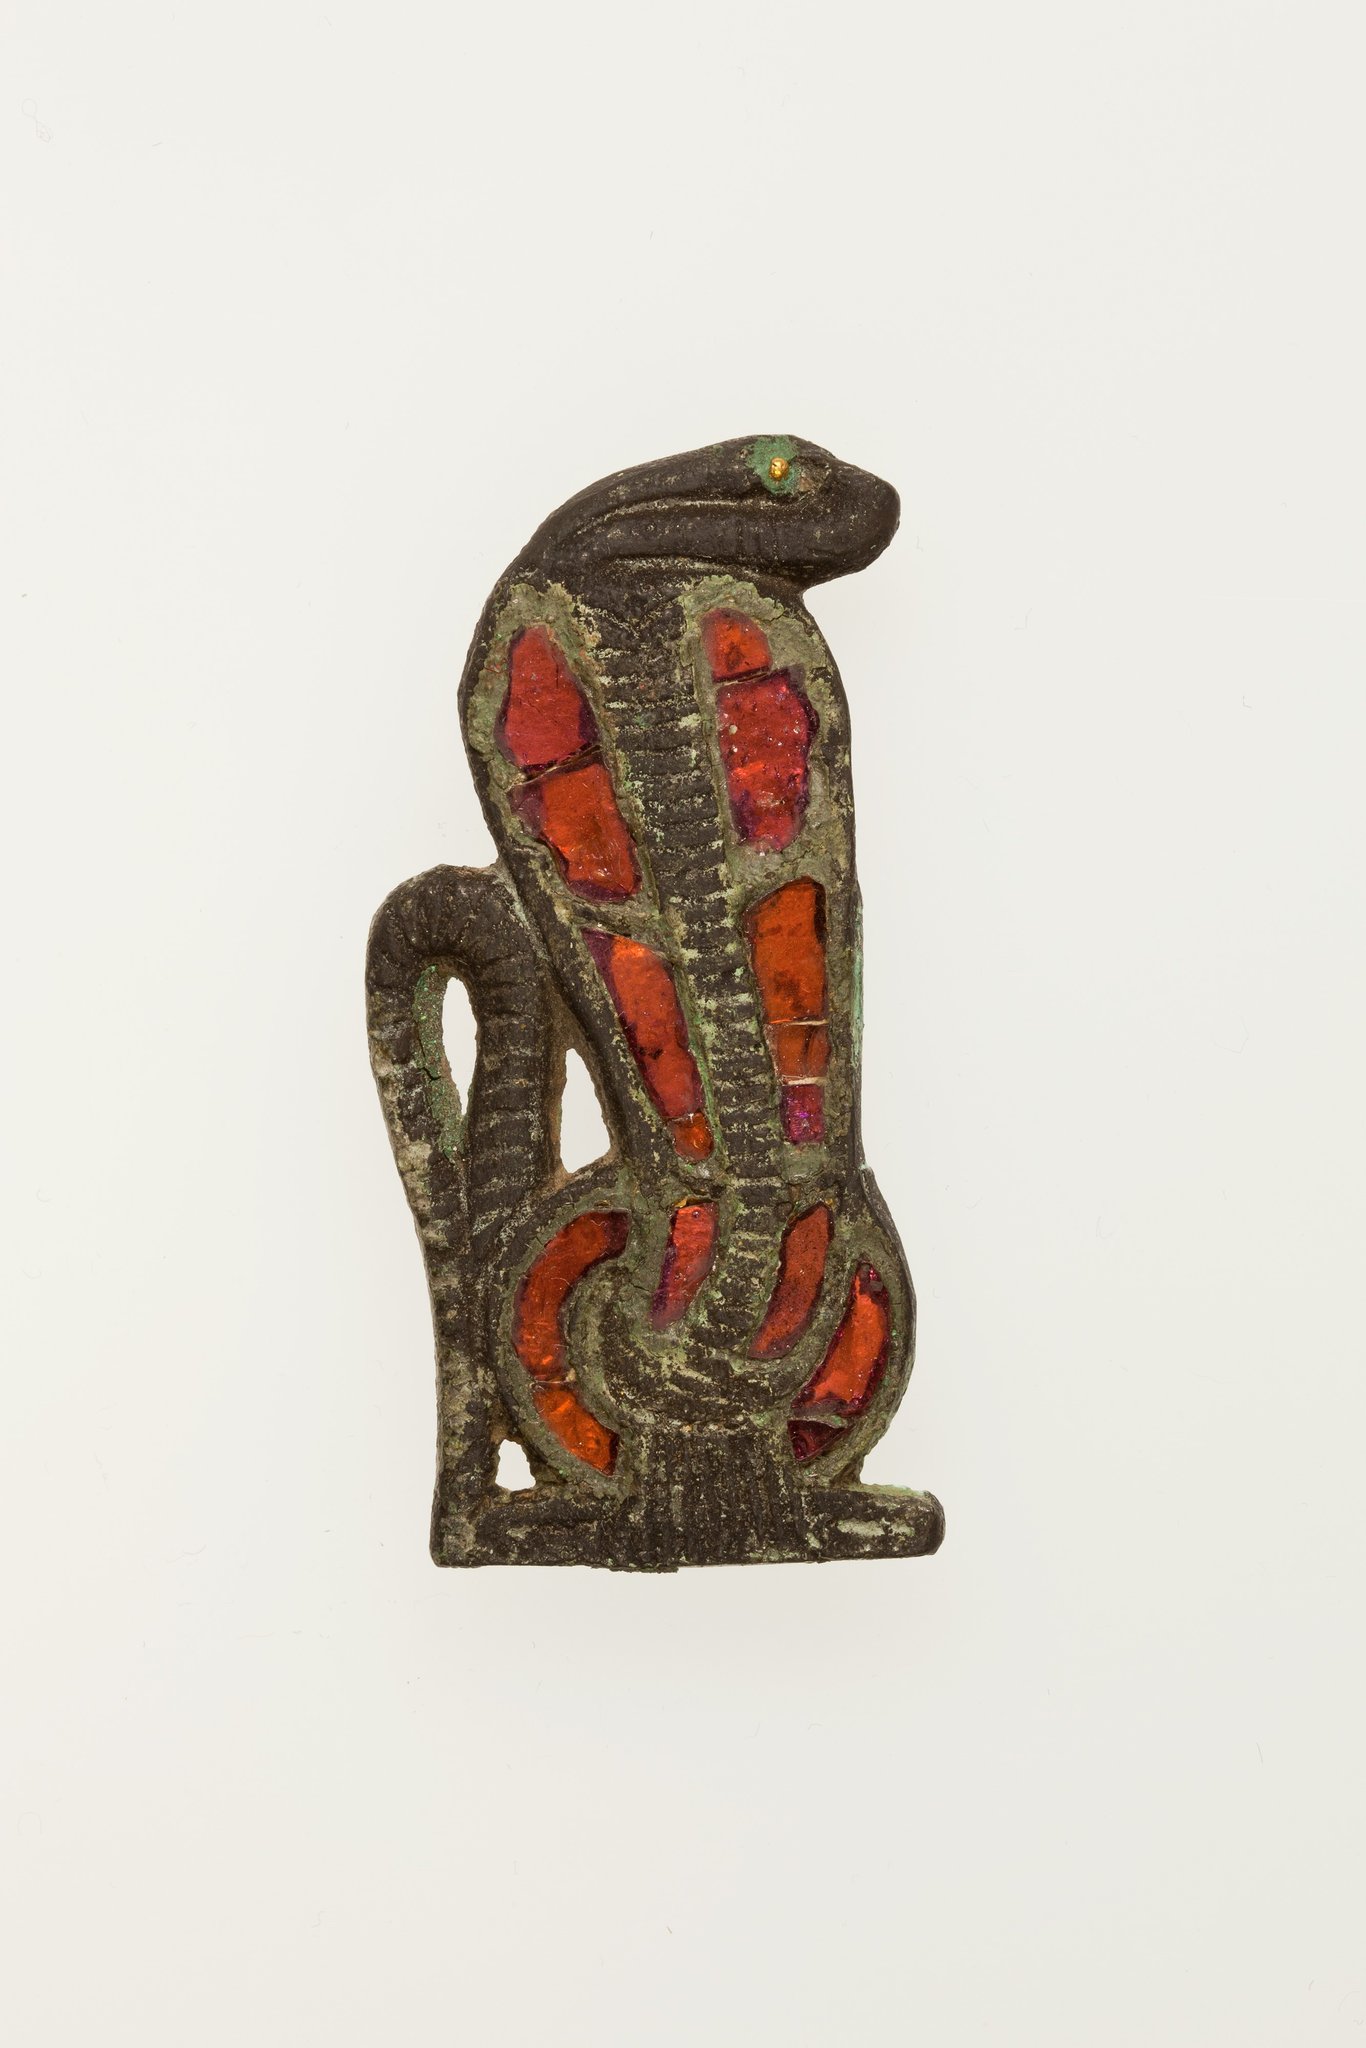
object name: attachment, uraeus, freize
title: Uraeus for freize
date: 664-630 BCE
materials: bronze, glass, gold leaf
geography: egypt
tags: serpents